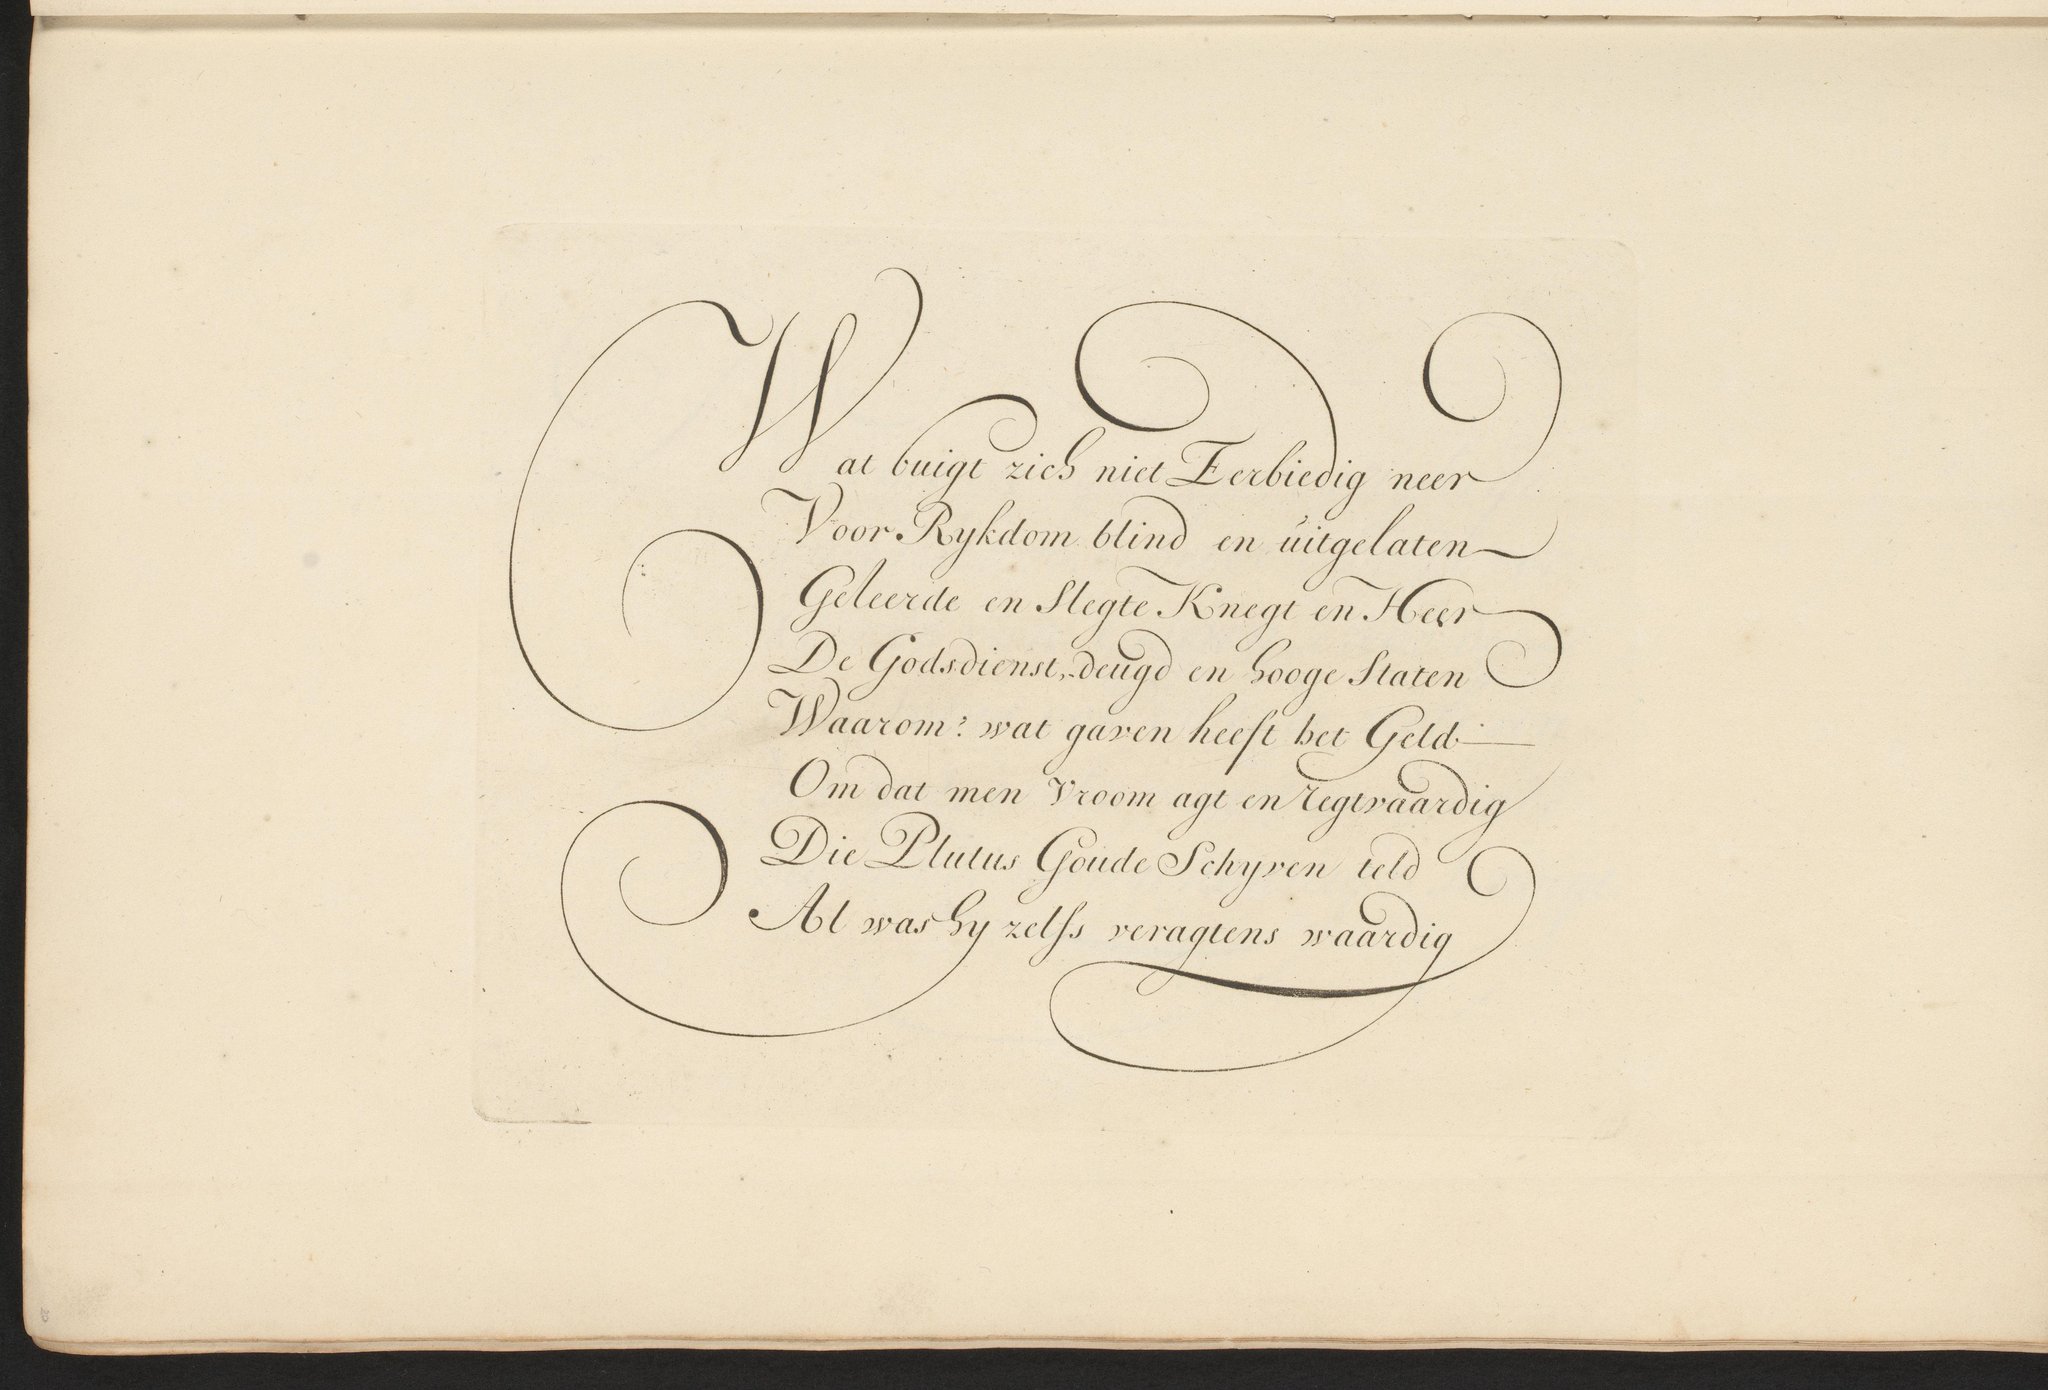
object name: ornament print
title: Schrijfvoorbeeld: Wat buigt zich niet Eerbiedig neer (...)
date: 1660-1751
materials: paper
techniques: engraving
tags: calligraphy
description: Schrijfvoorbeeld met acht regels tekst in het Nederlands: Wat buigt zich niet Eerbiedig neer ... De prent maakt deel uit van een album